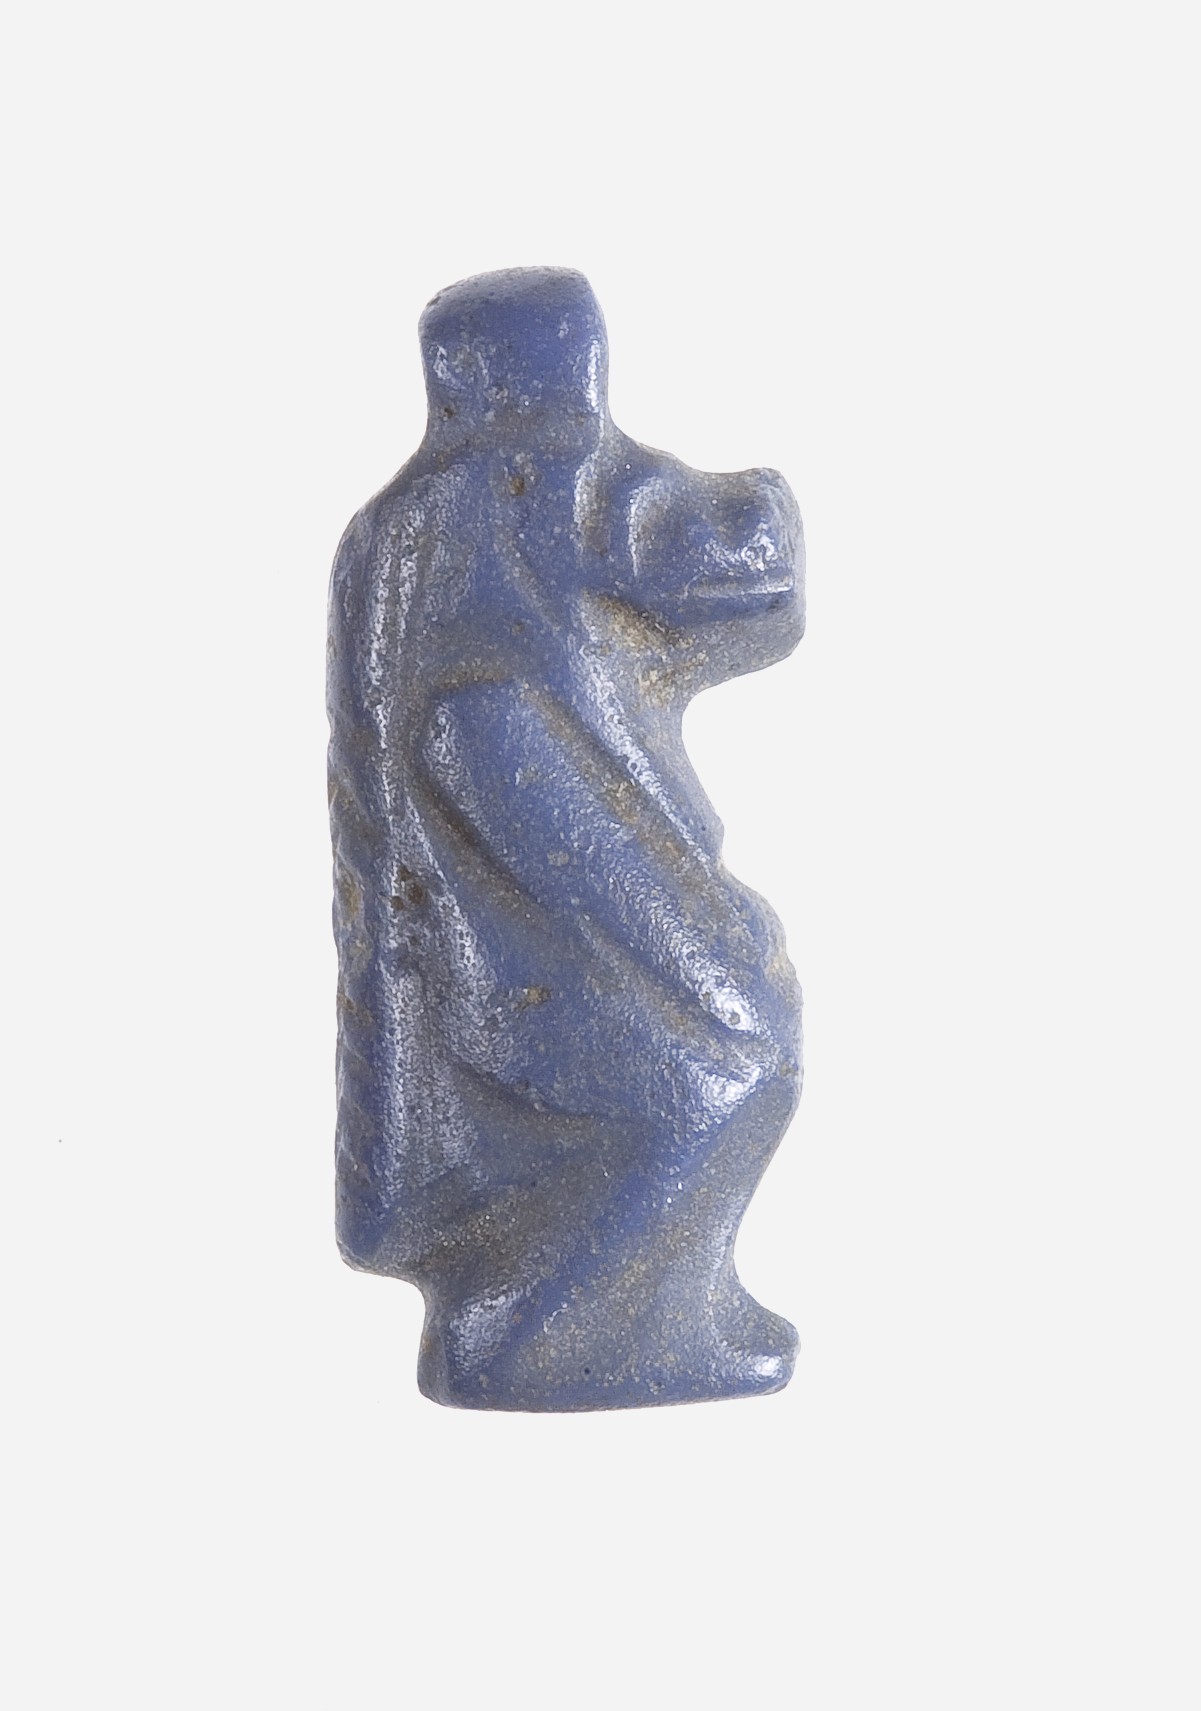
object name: necklace, bead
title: Amulet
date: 1550-1295 BCE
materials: glass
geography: egypt